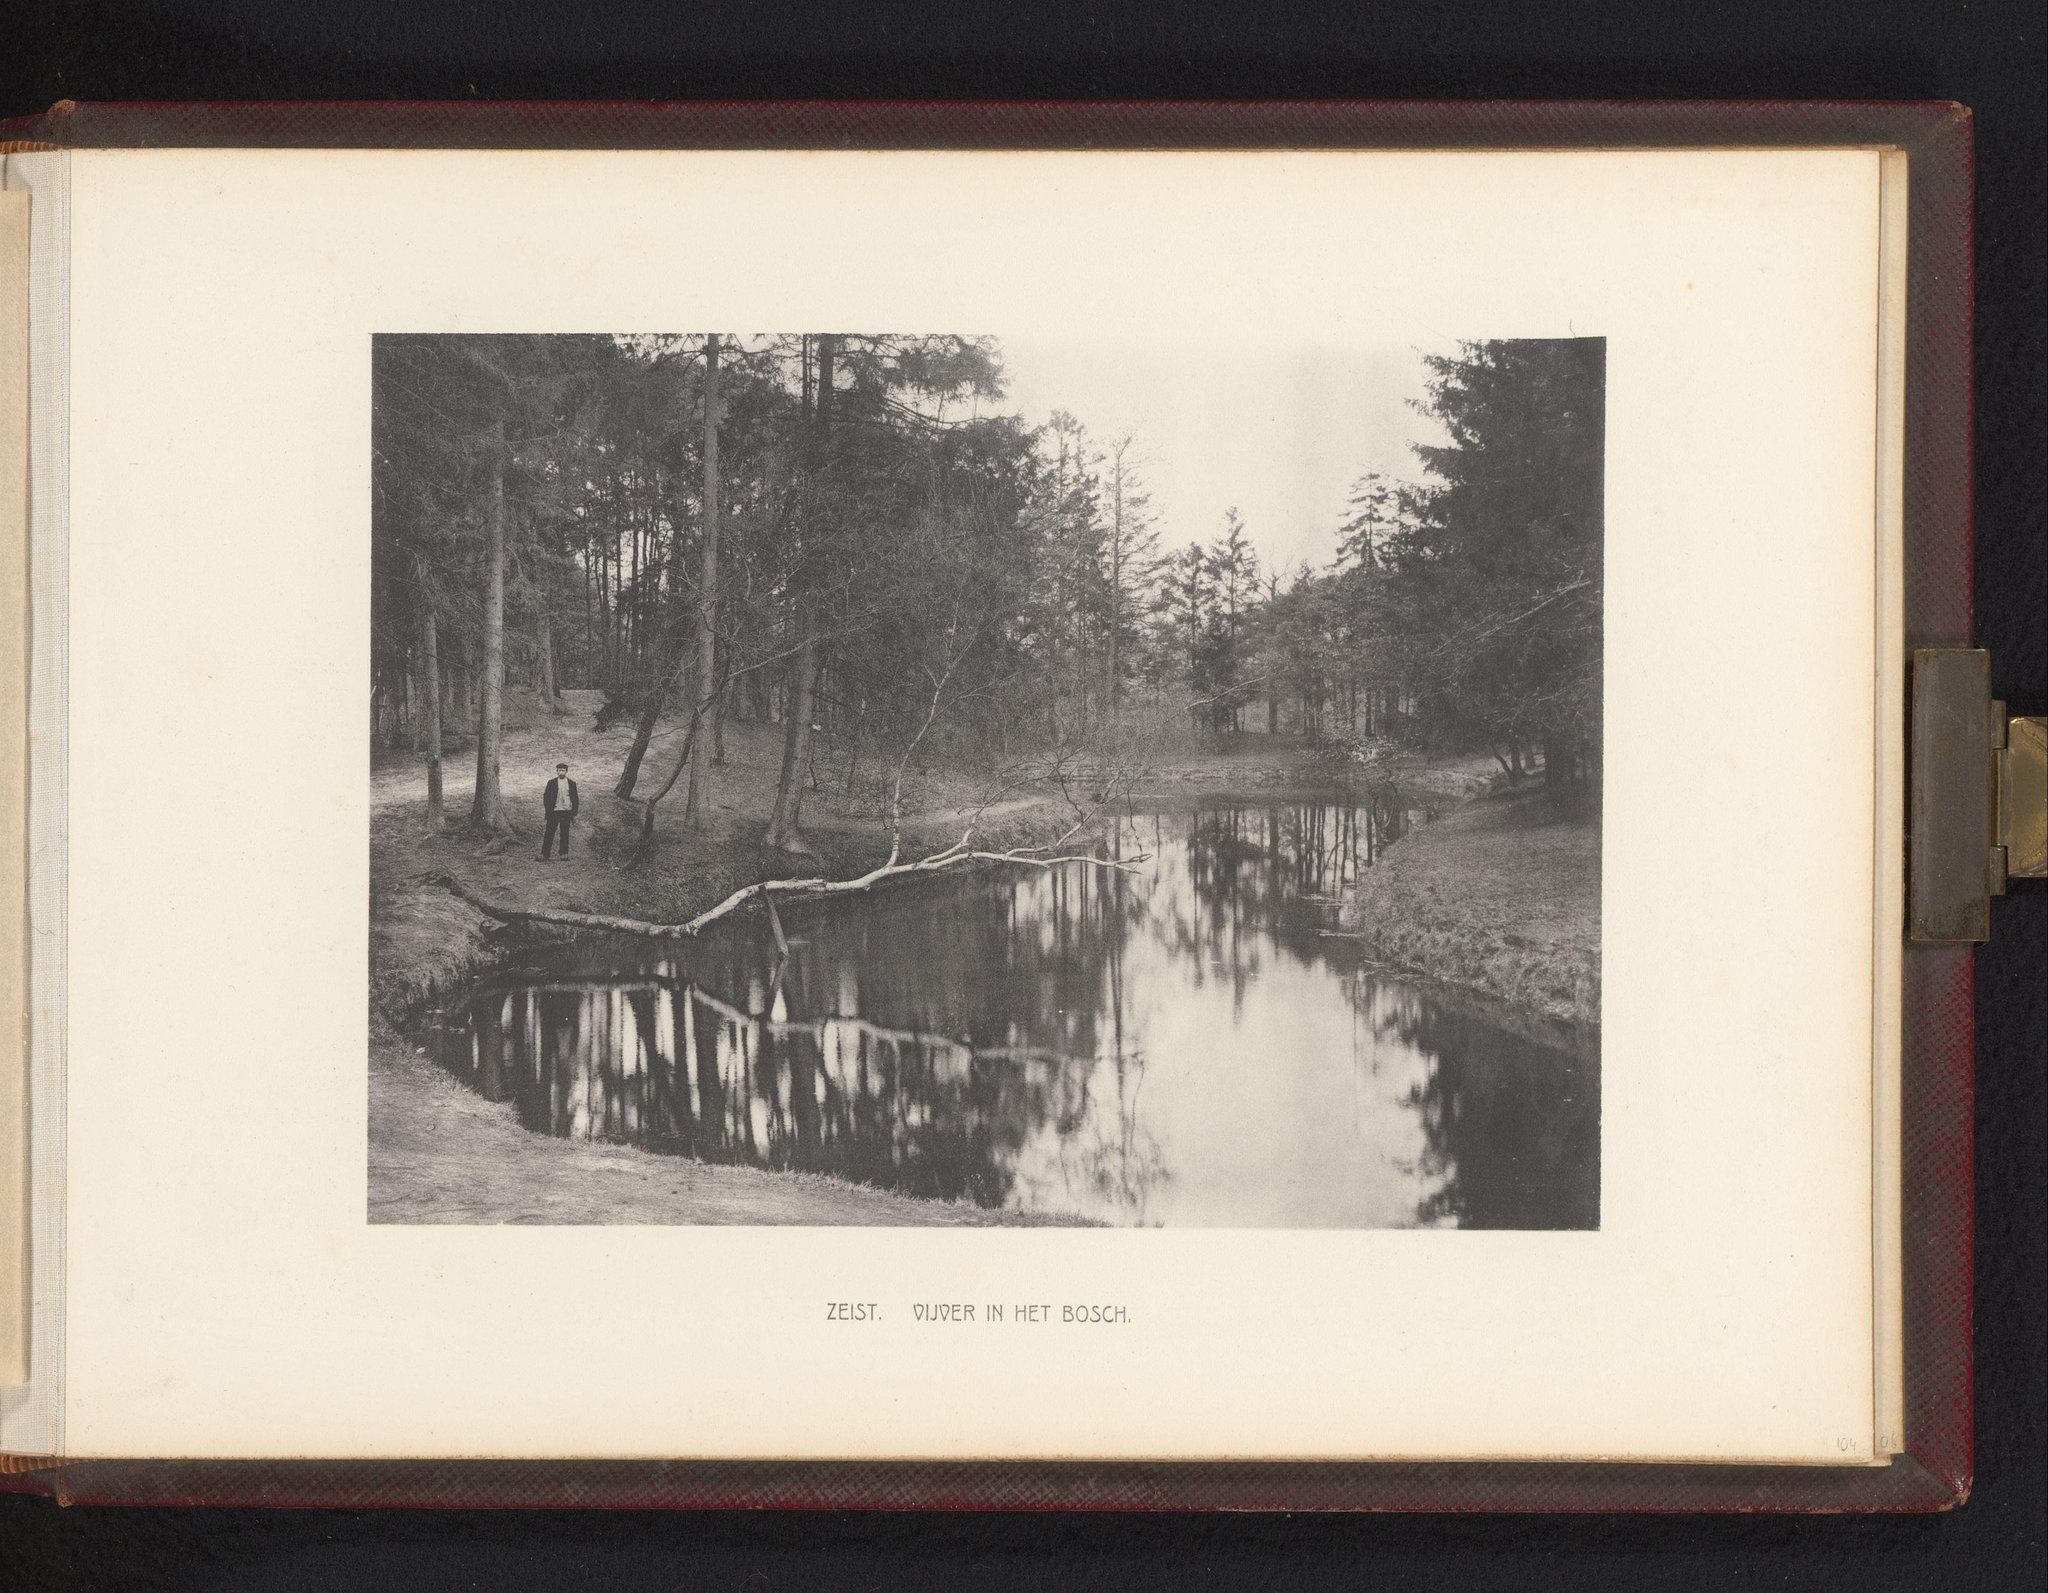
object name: photomechanical print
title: Zeist Vijver in het bosch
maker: Anonymous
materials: paper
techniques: photograph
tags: youth, adolescent, forest, wood, pond, pool, zeist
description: Deze pagina maakt deel uit van een album.